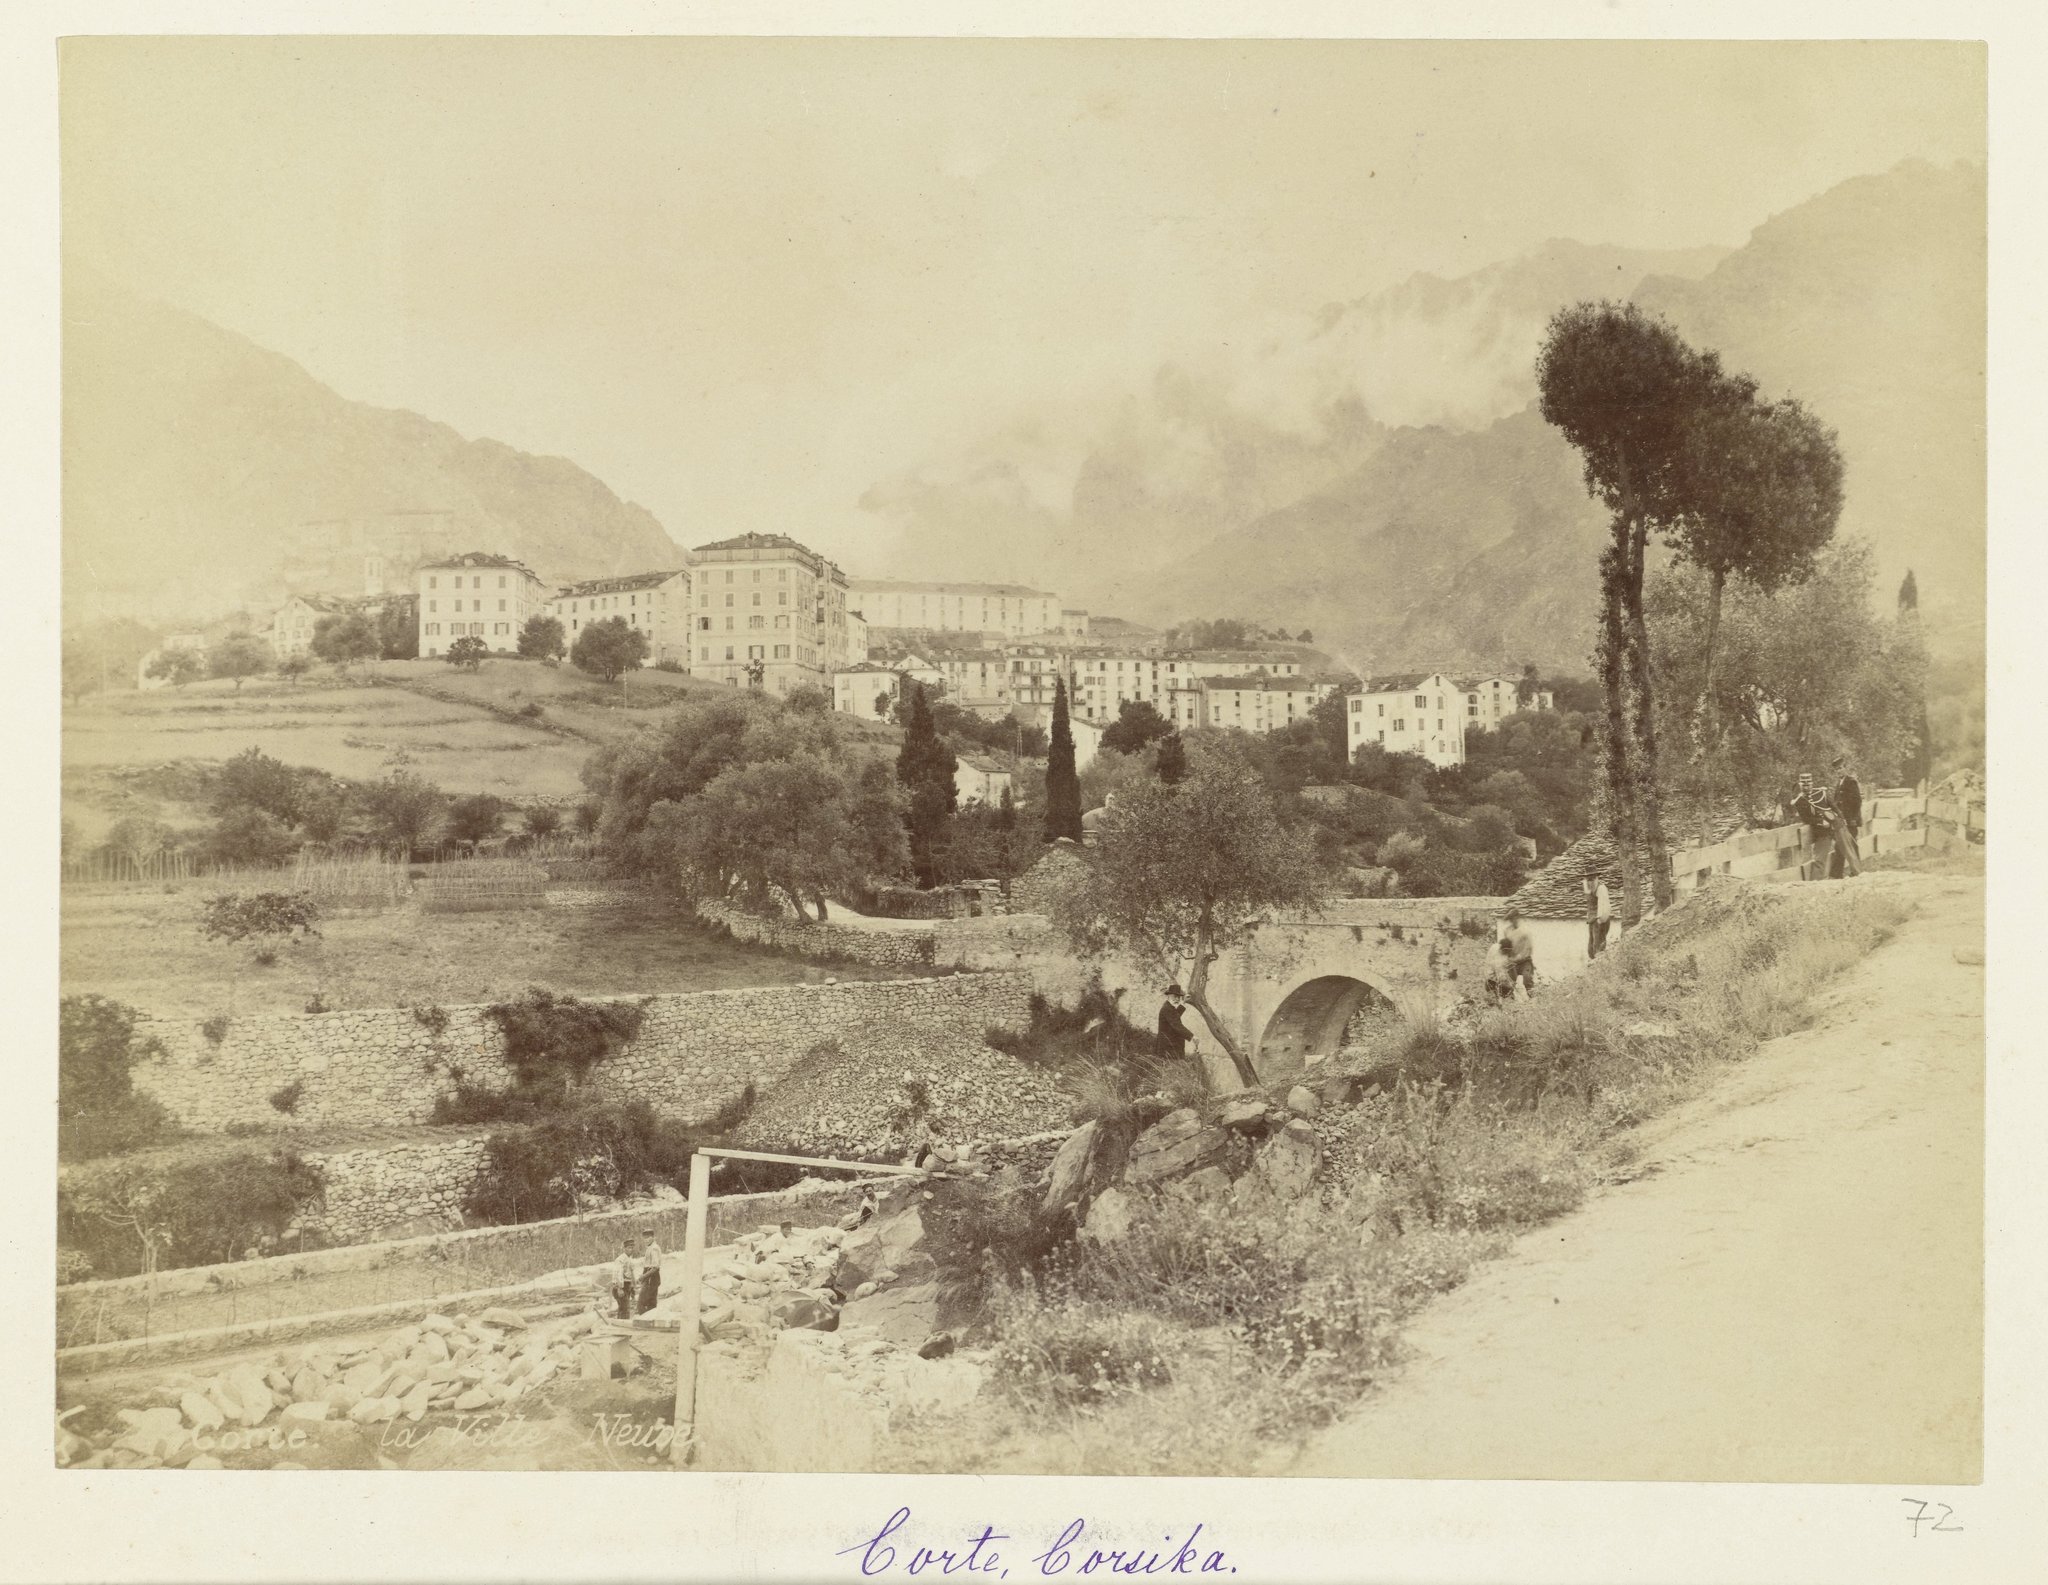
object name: photograph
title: Corte , Corsika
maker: henry pauw van wieldrecht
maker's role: fotograaf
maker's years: 1863-1912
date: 1886-1896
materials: cardboard, photographic support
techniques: albumen print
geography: corsica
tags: corsica